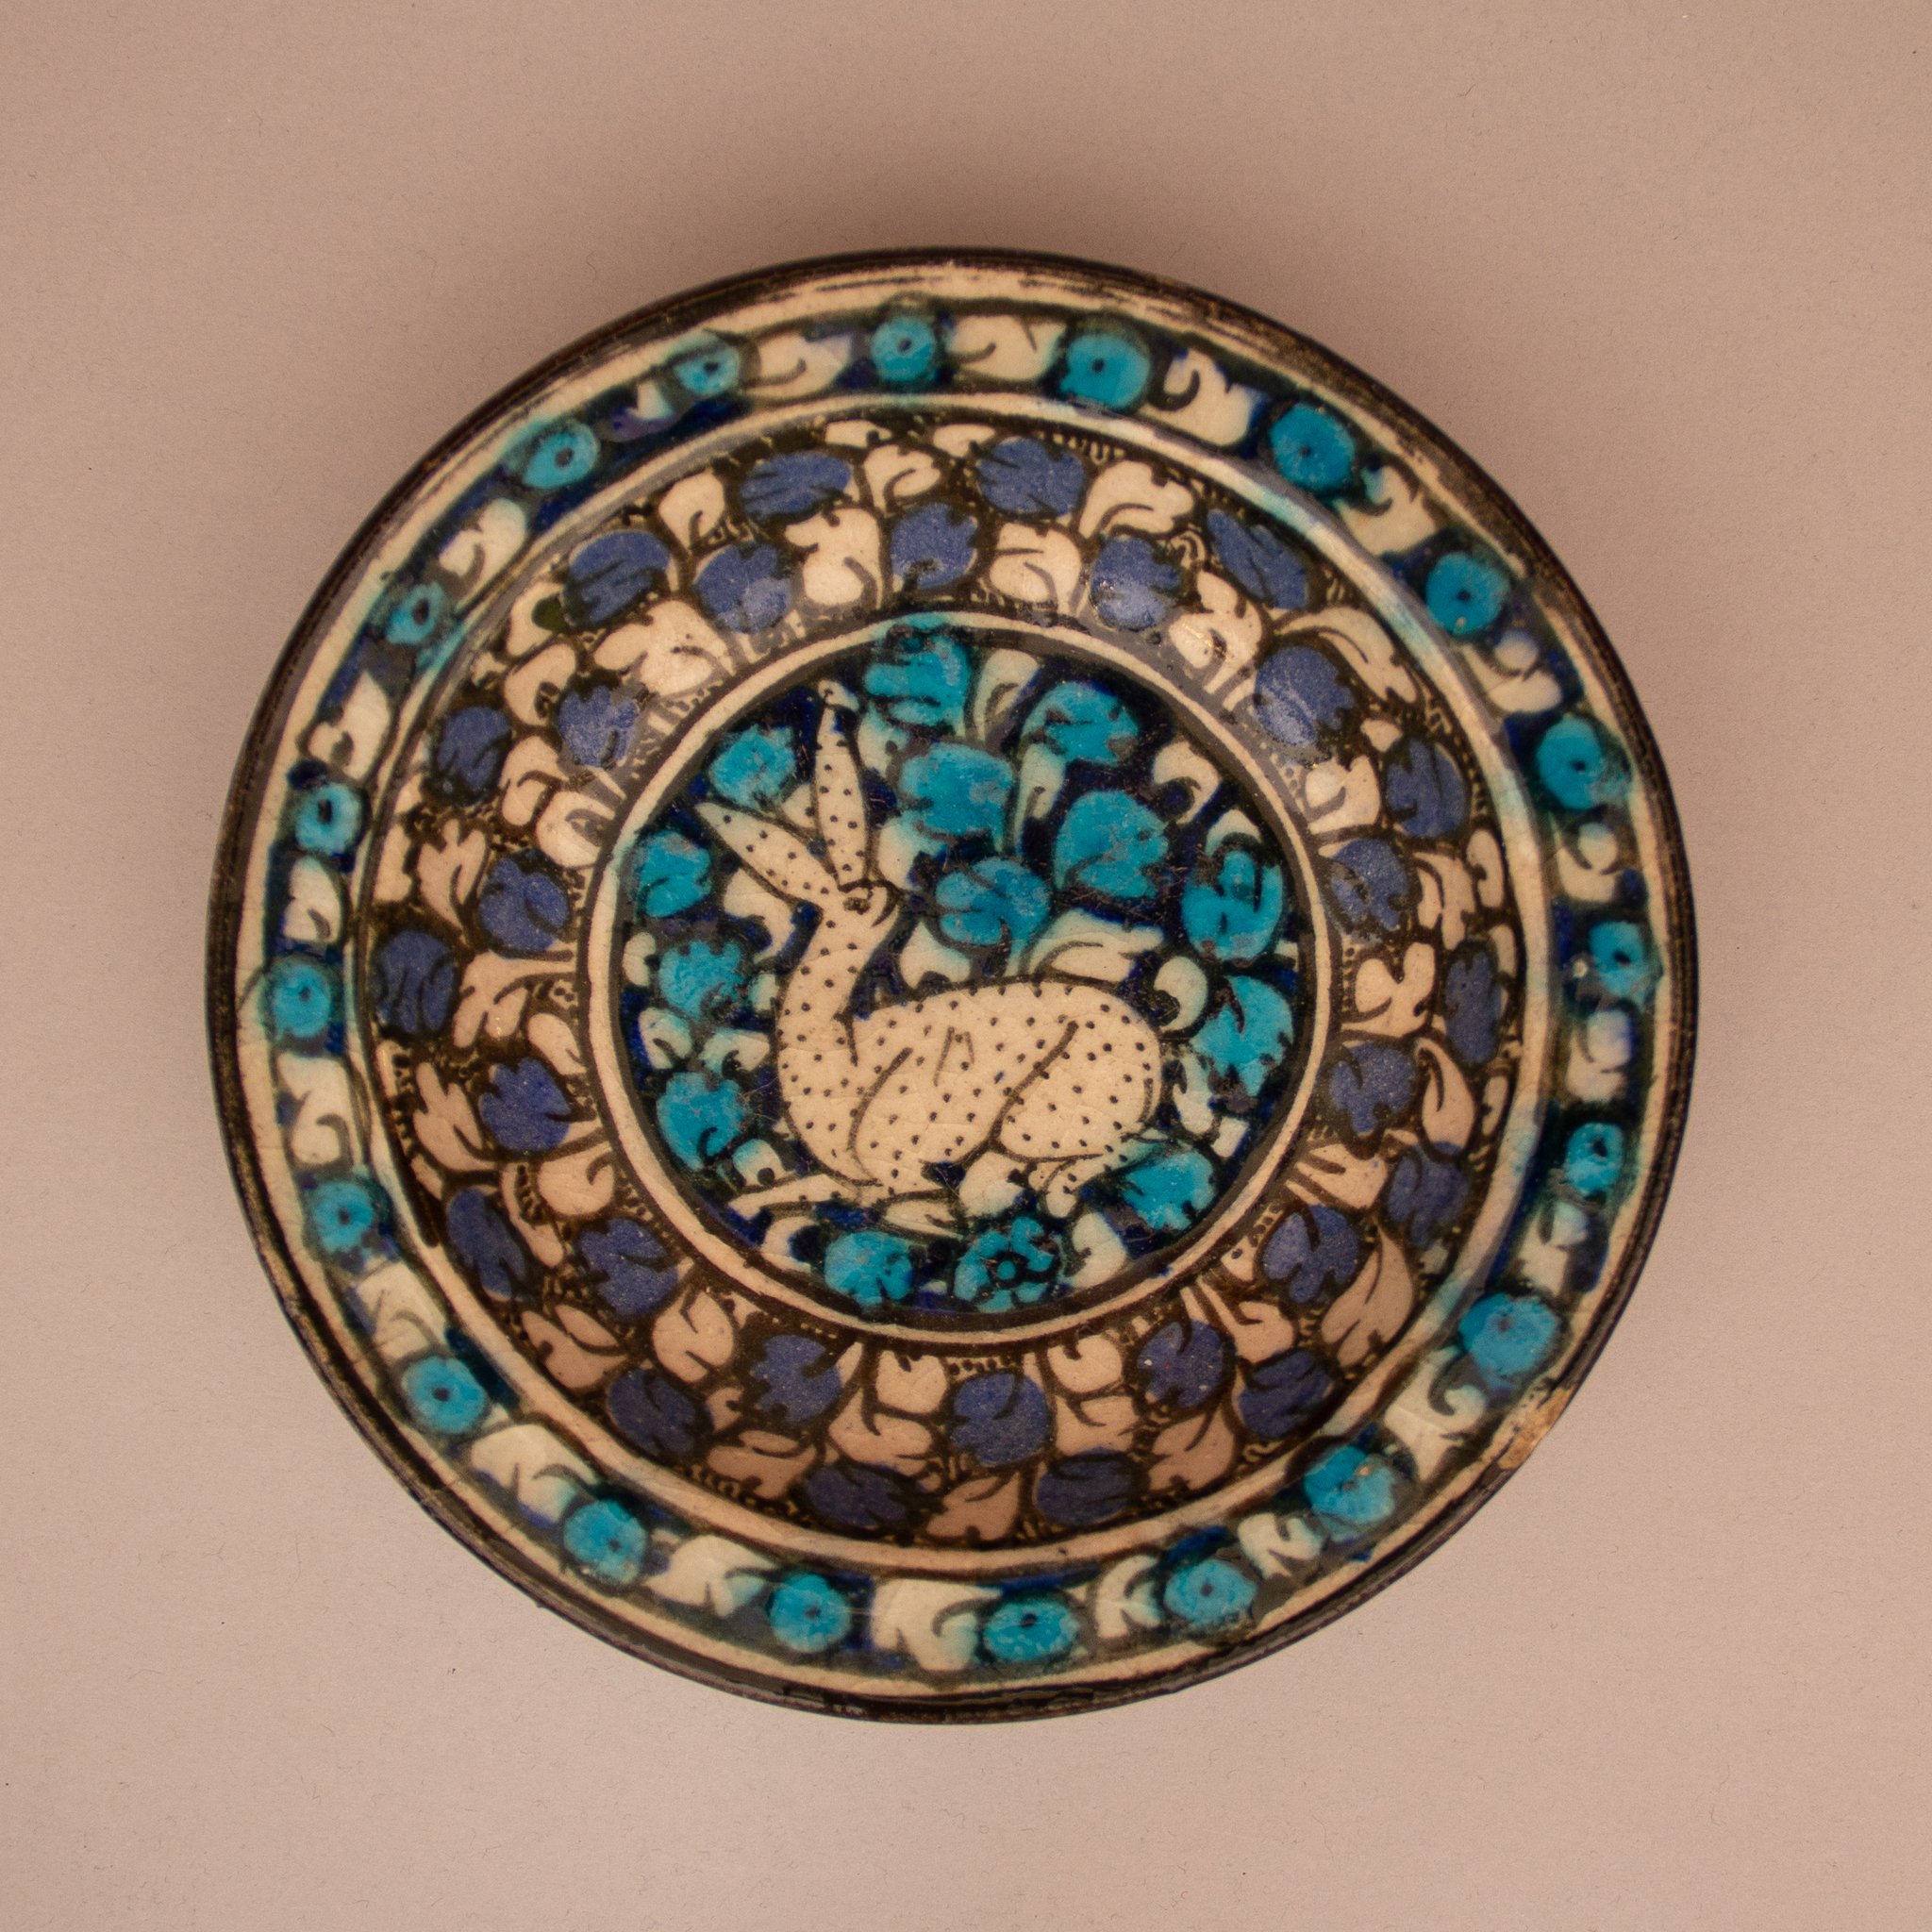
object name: dish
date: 1301-1400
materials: earthenware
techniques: painting, underglaze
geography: iran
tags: rabbits